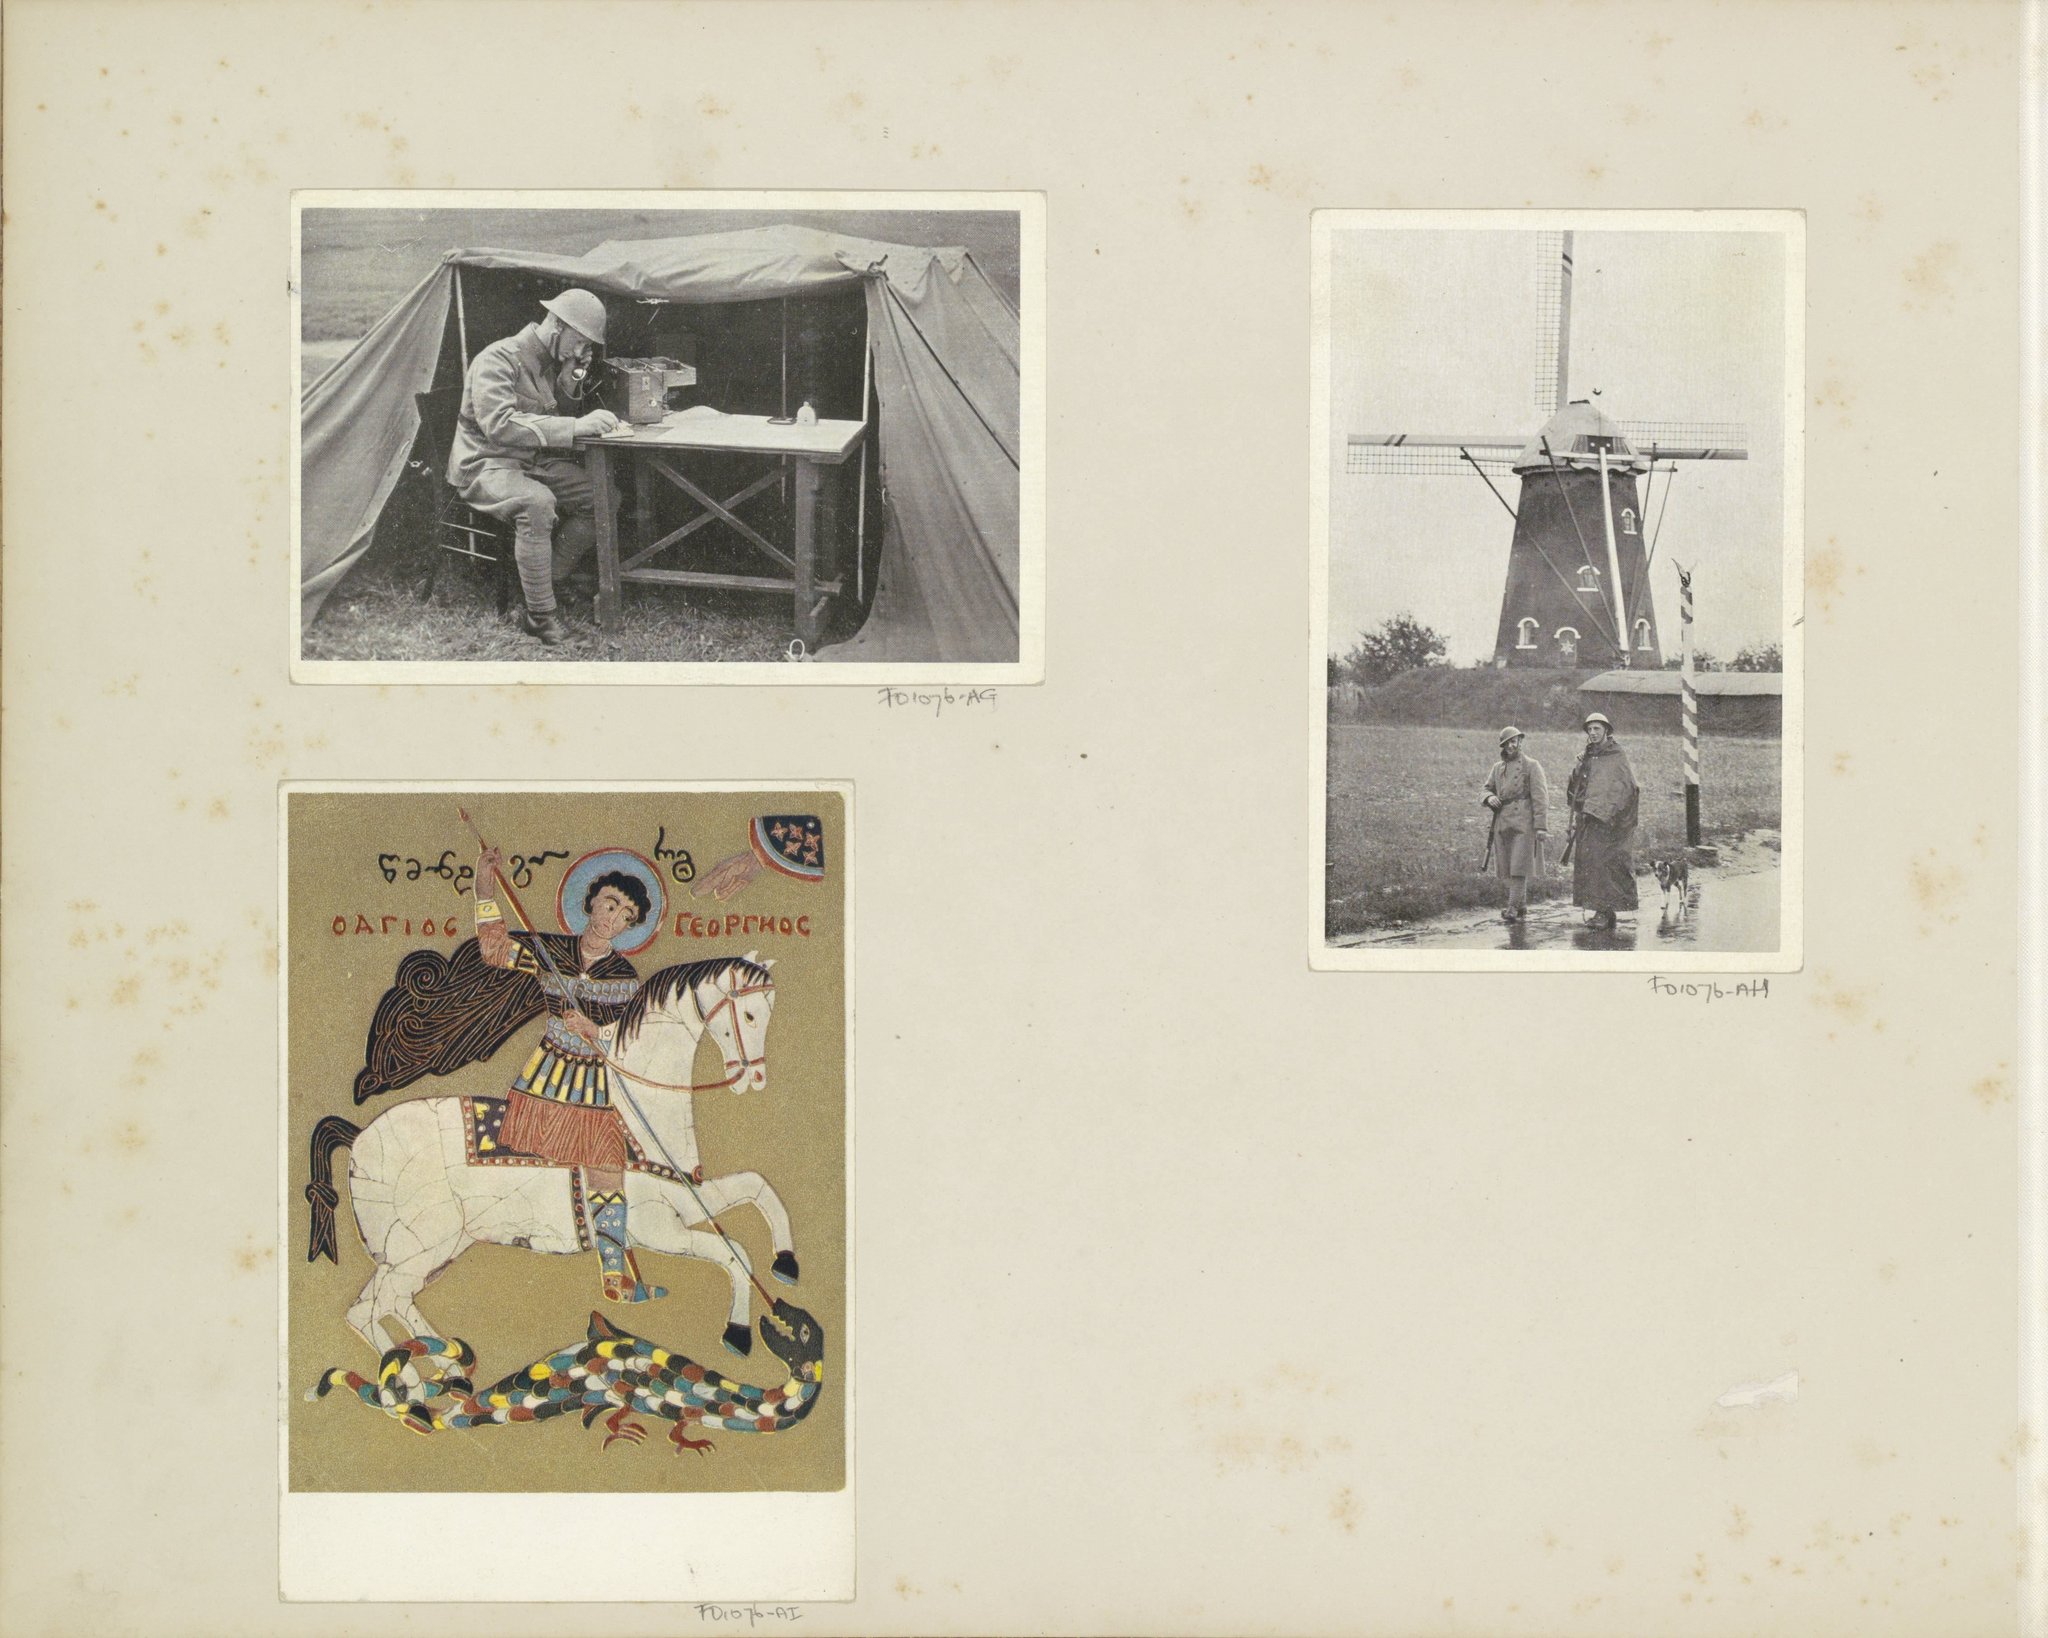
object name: album leaf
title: Militair met veldtelefoon zittend voor een tent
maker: Anonymous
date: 1914-1945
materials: cardboard, paper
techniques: autotype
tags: (military) camp with tents, post, telegraph and telephone; means of communication, land forces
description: Onderdeel van Album met foto's van spoorwegen in Nederlands-Indië en prentbriefkaarten.